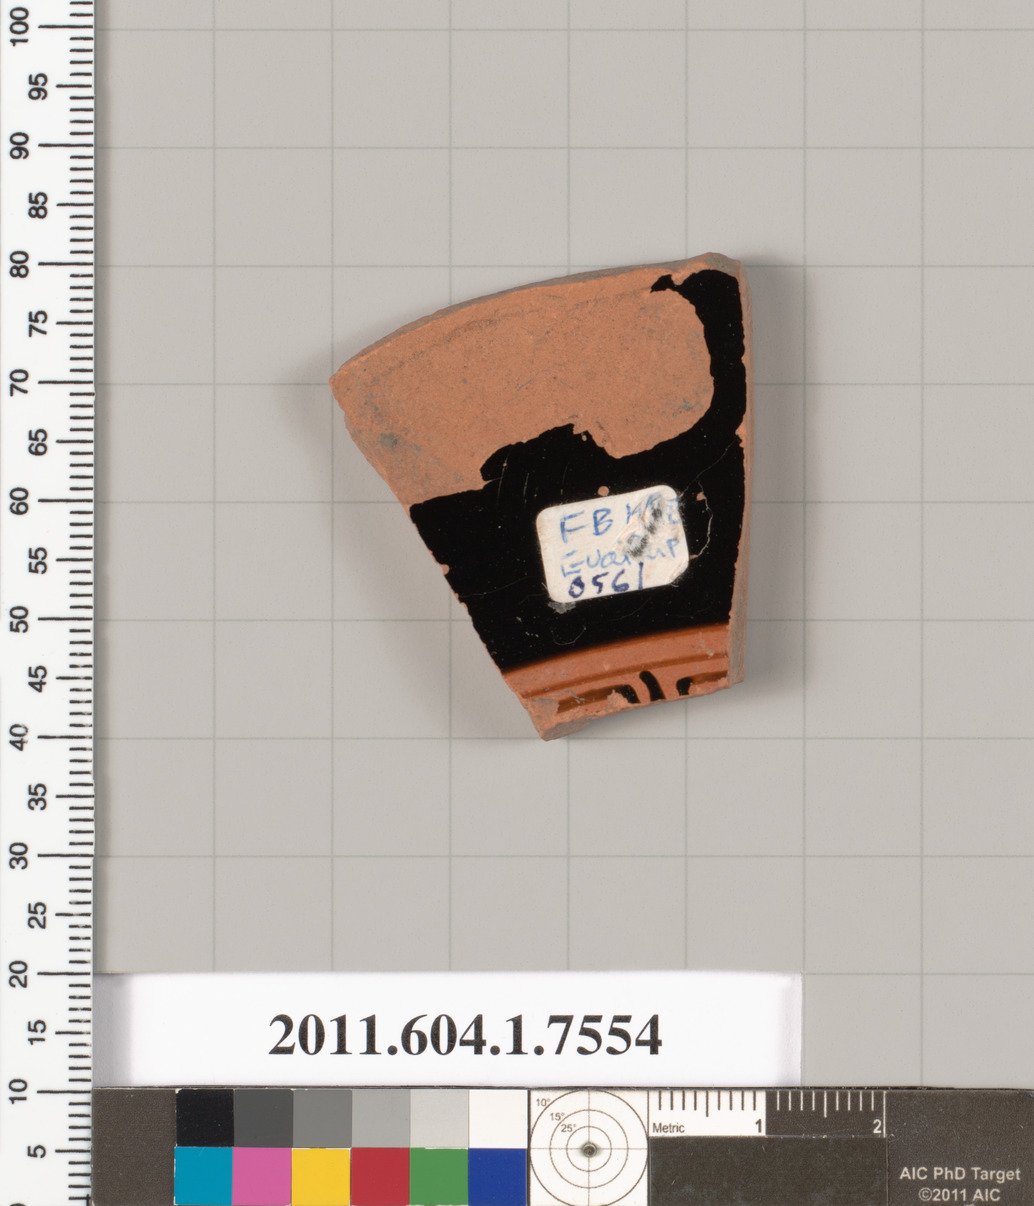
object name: kylix fragment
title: Terracotta fragment of a kylix (drinking cup)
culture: greek, attic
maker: euaion painter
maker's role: artist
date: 460-450 BCE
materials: terracotta